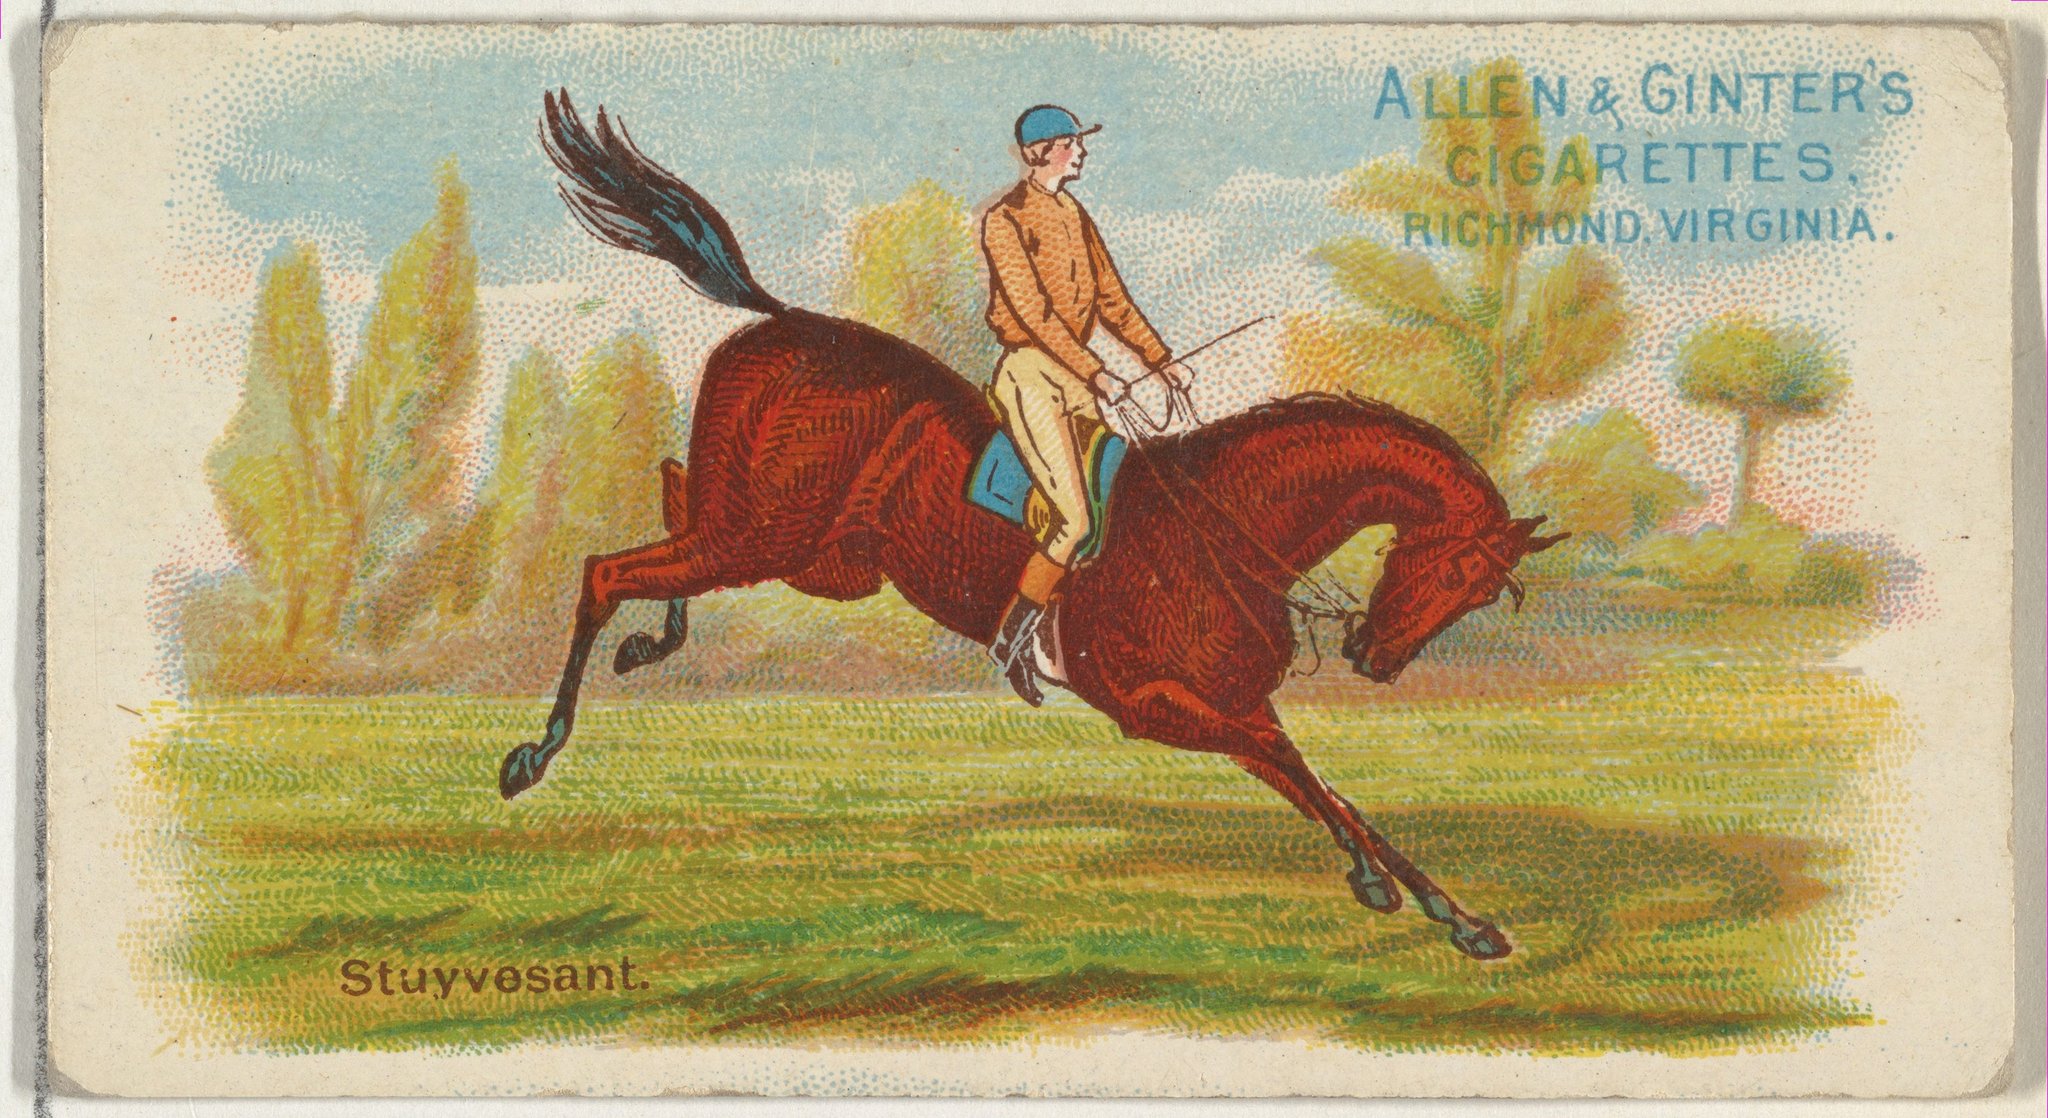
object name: print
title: Stuyvesant, from The World's Racers series (N32) for Allen & Ginter Cigarettes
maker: allen & ginter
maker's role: publisher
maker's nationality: american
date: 1888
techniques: color lithograph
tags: men,horses,jockeys